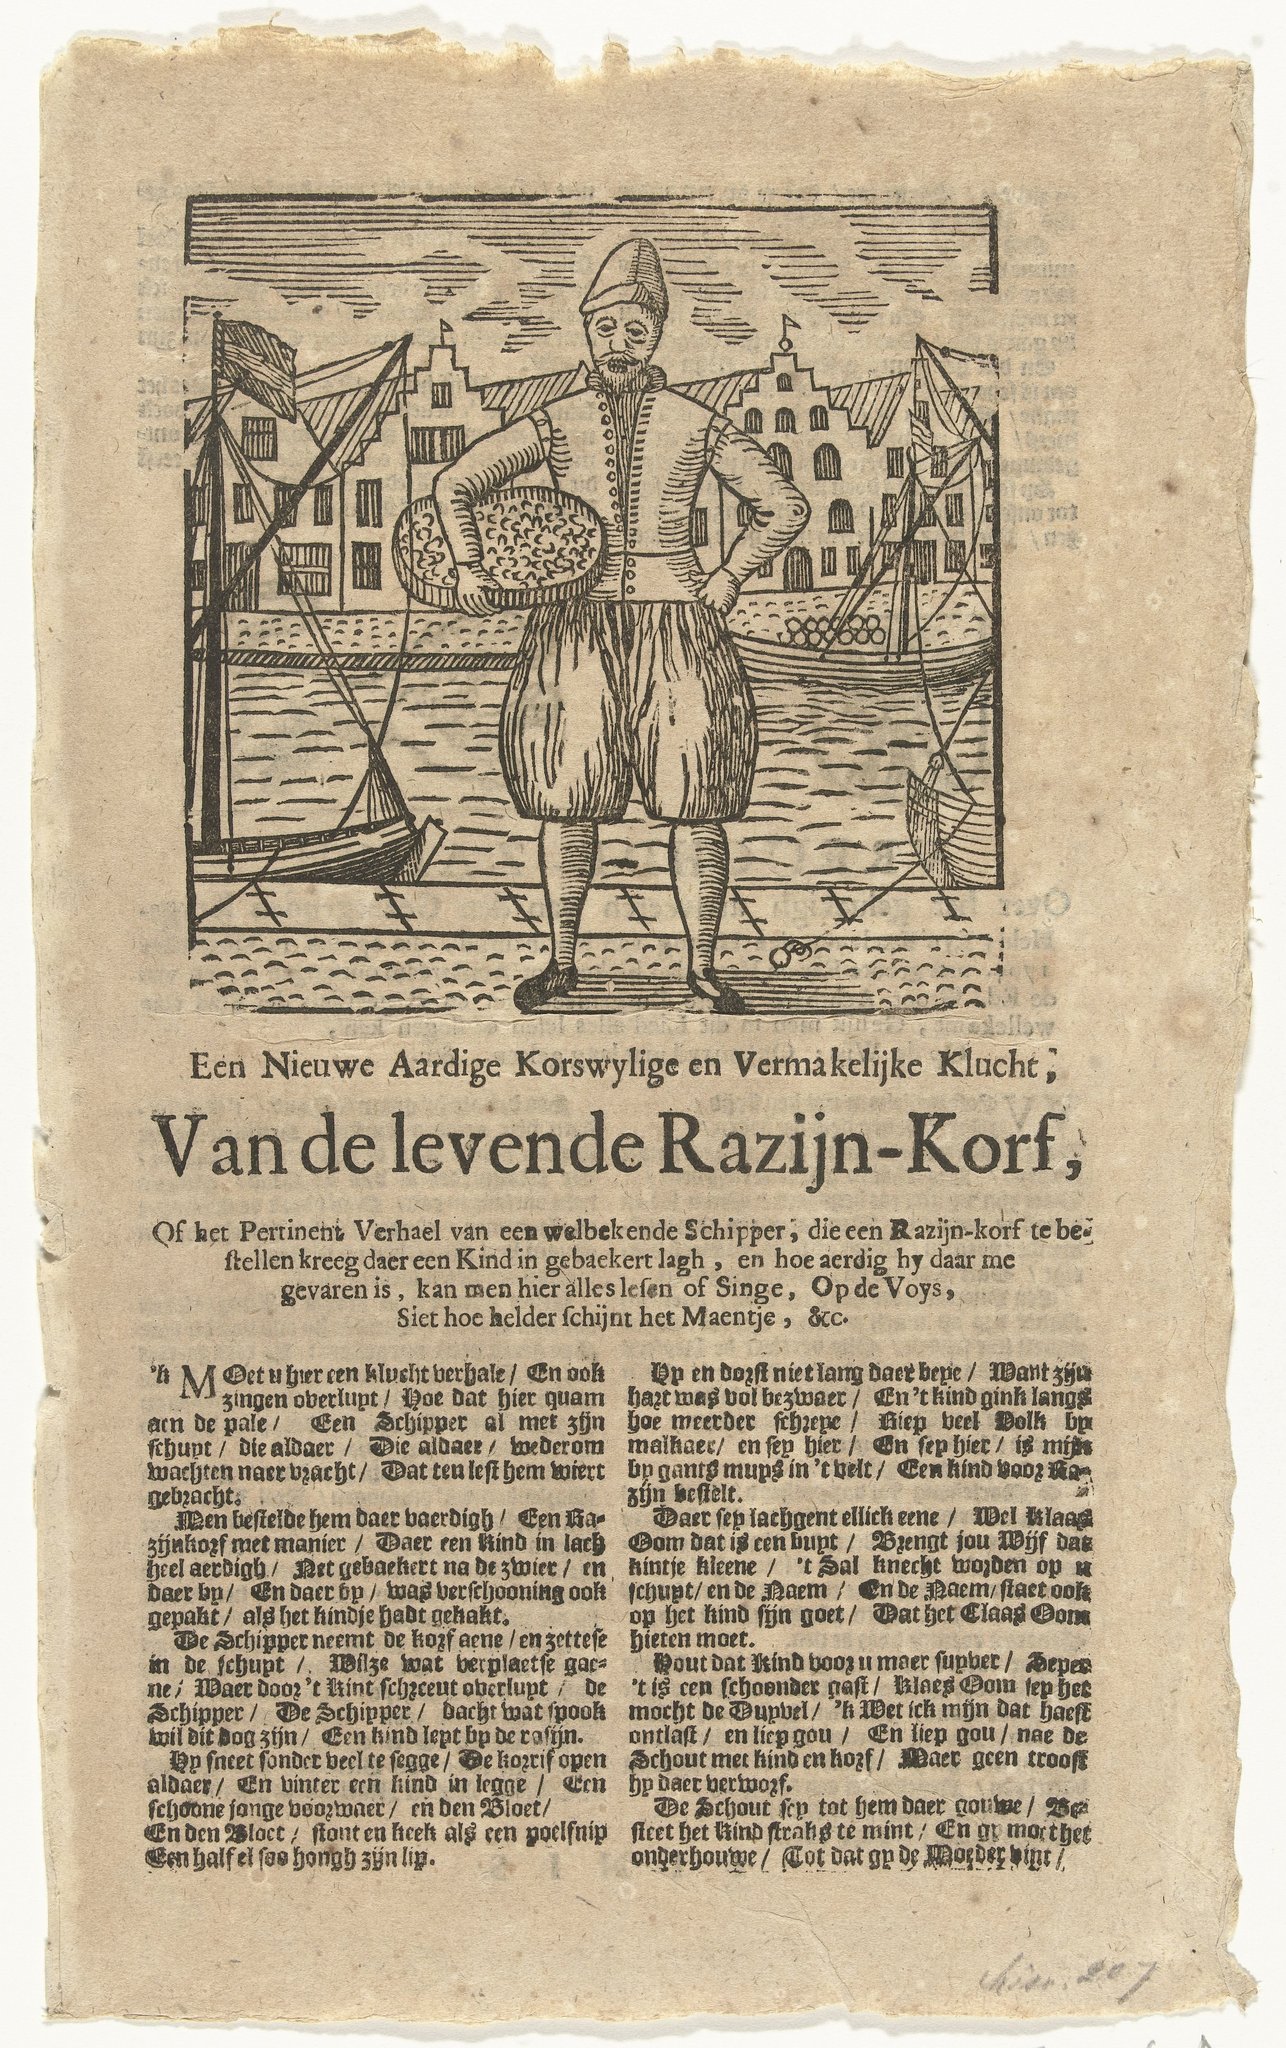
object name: print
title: Een Nieuwe Aarduge Korswylige en Vermakelijke Klucht, Van de levende Razijn-Korf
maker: Anonymous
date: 1704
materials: paper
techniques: letterpress printing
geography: northern netherlands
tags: seaman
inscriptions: : ‘.’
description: Blad met een vers en voorstelling van een schipper die een gebakerd kind in een razijn-korf (rozijnenmand) vond, ca. 1704. Voorstelling van een schipper staande aan de kade met een mand in hand, daaaronder het lied in twee kolommen.